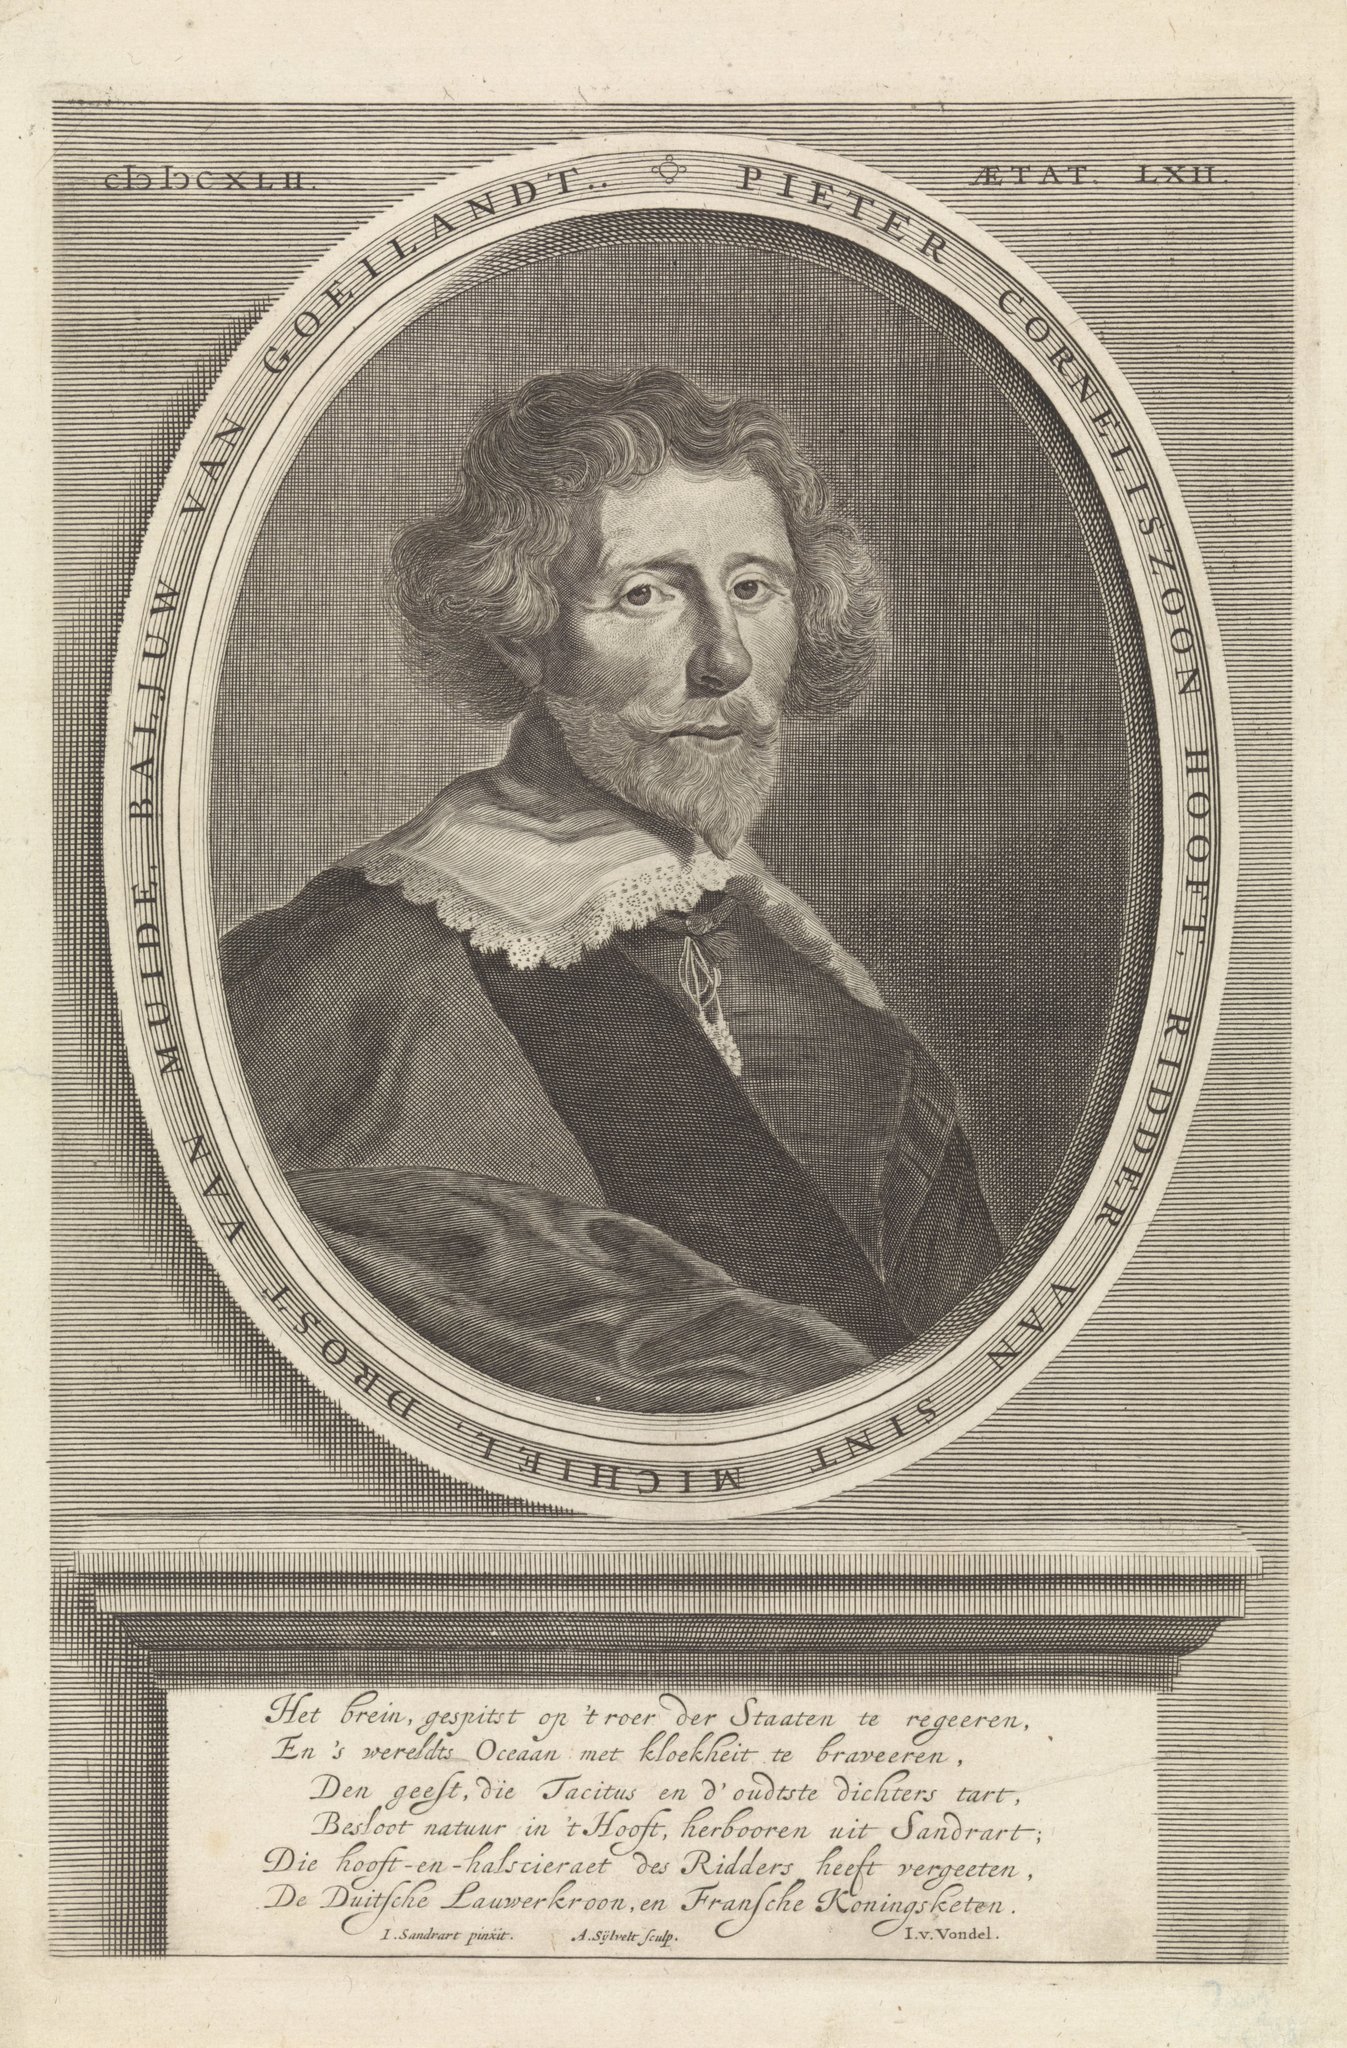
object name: print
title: Portret van Pieter Cornelisz. Hooft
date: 1677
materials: paper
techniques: engraving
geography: amsterdam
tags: amsterdam, the hague, pieter corneliszoon hooft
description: Prent gebruikt in: Hooft, Pieter Corneliszoon. Nederlandsche historien. Amsterdam: Joannes van Someren, Abraham Wolfgang, Dirk Boom (I), Hendrick Boom en Jacob de Jonge, 1677.